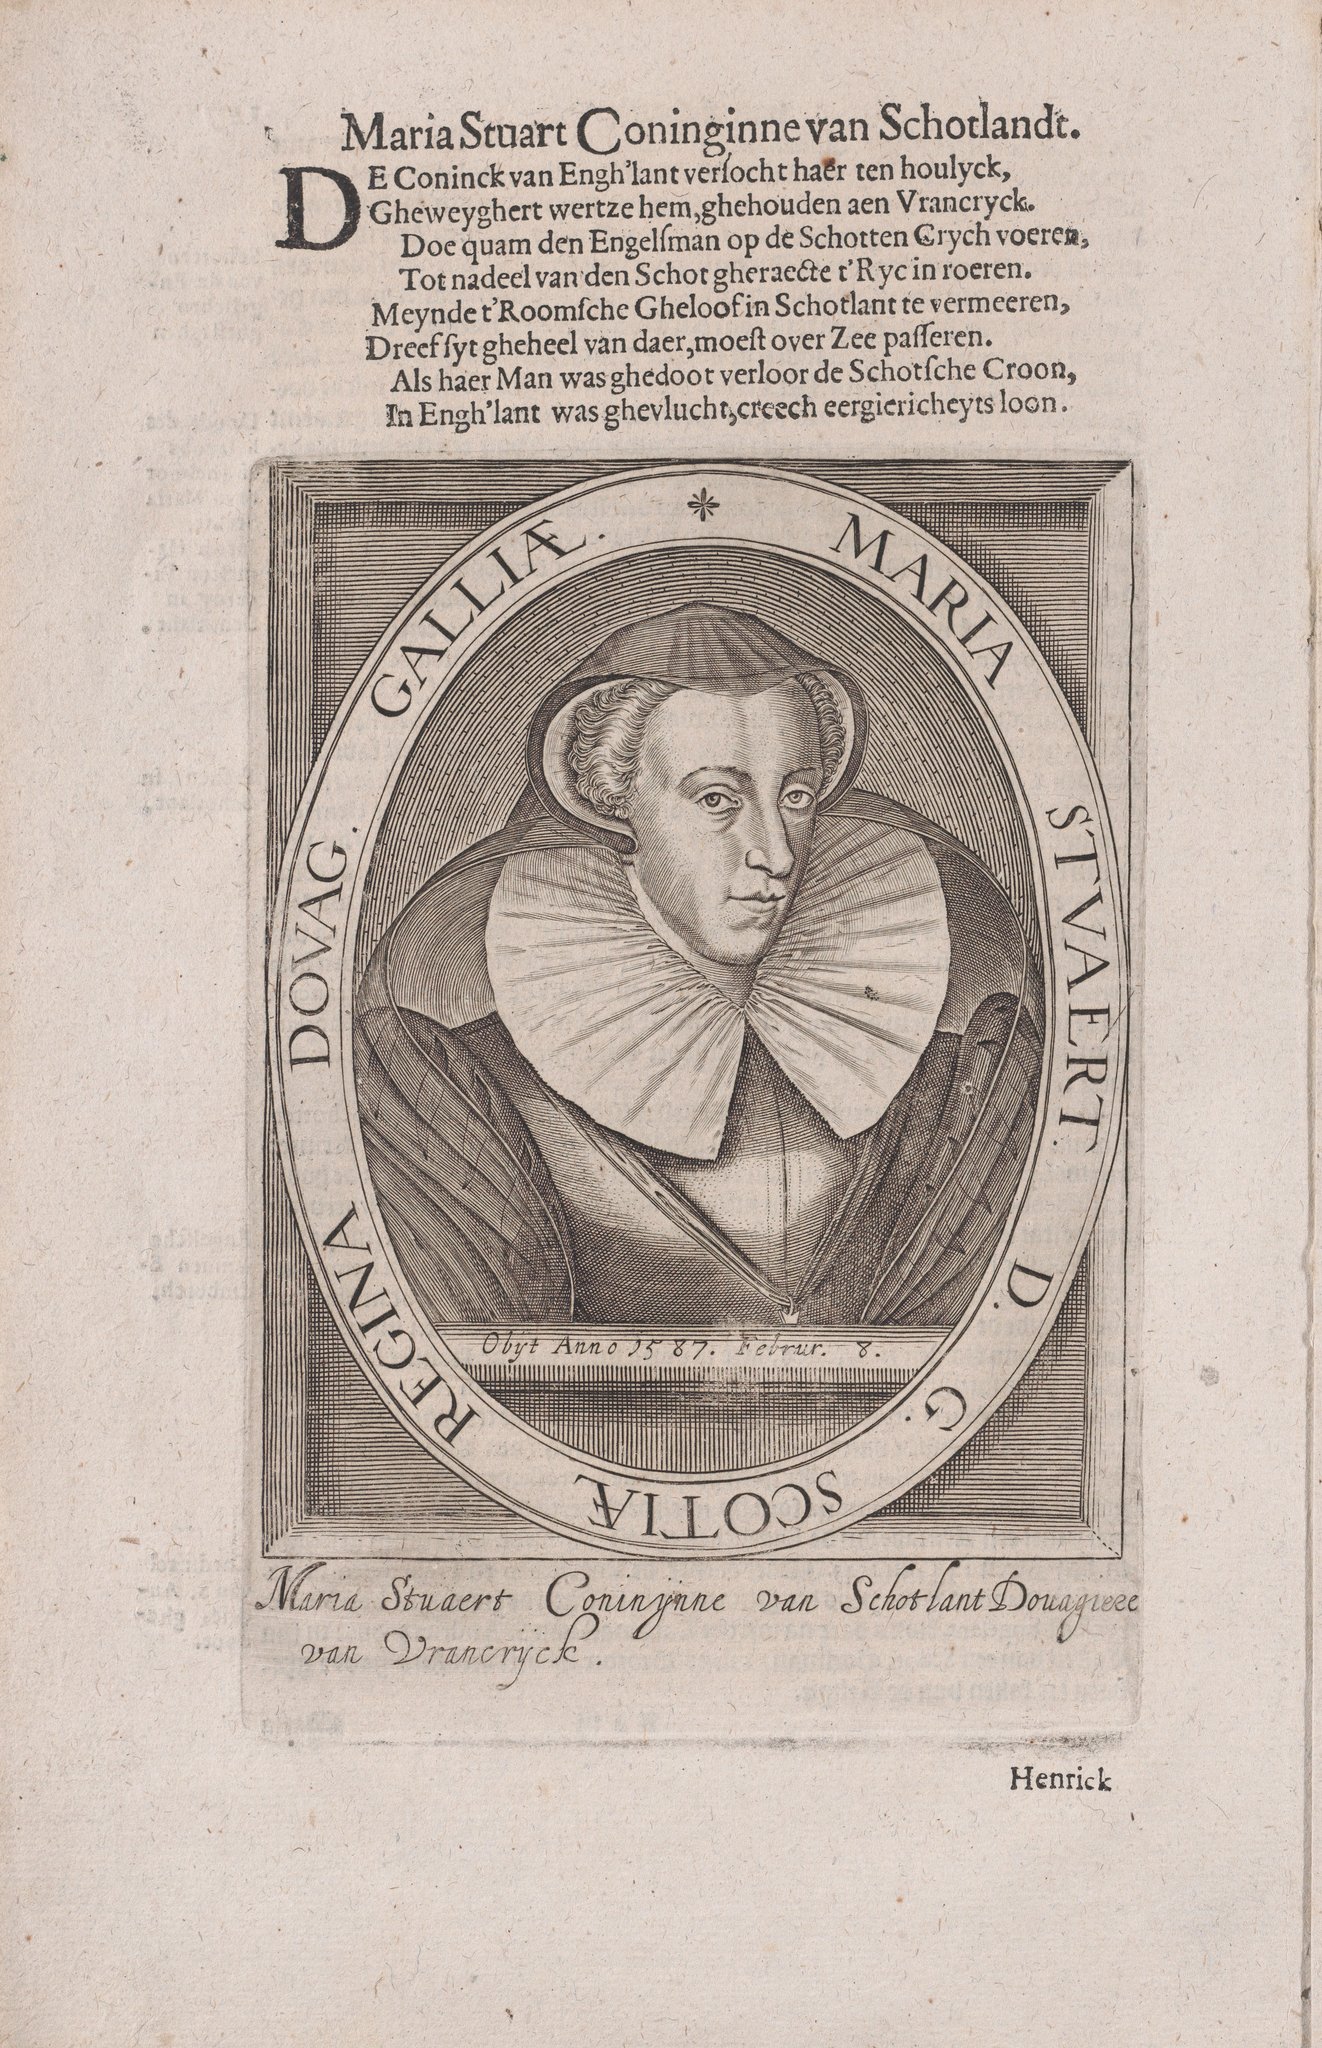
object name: print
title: Mary, Queen of Scots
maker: mary, queen of scots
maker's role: sitter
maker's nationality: scottish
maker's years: 1542-1587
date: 1601-1700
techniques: engraving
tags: queens,portraits,women,mary queen of scots